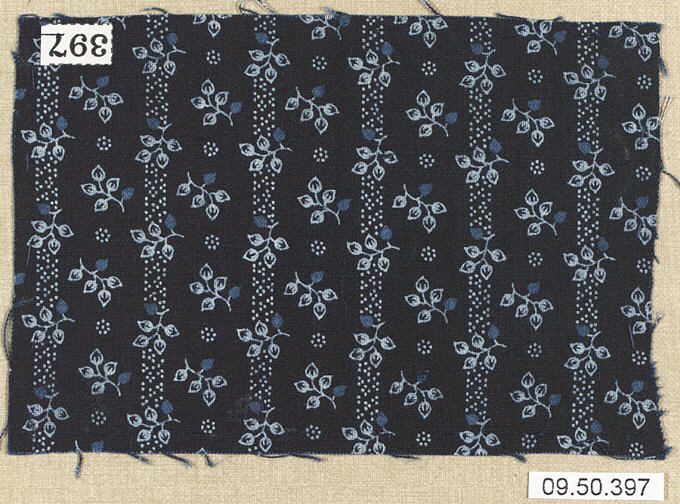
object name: piece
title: Piece (one of 116)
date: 1801-1900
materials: cotton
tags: leaves